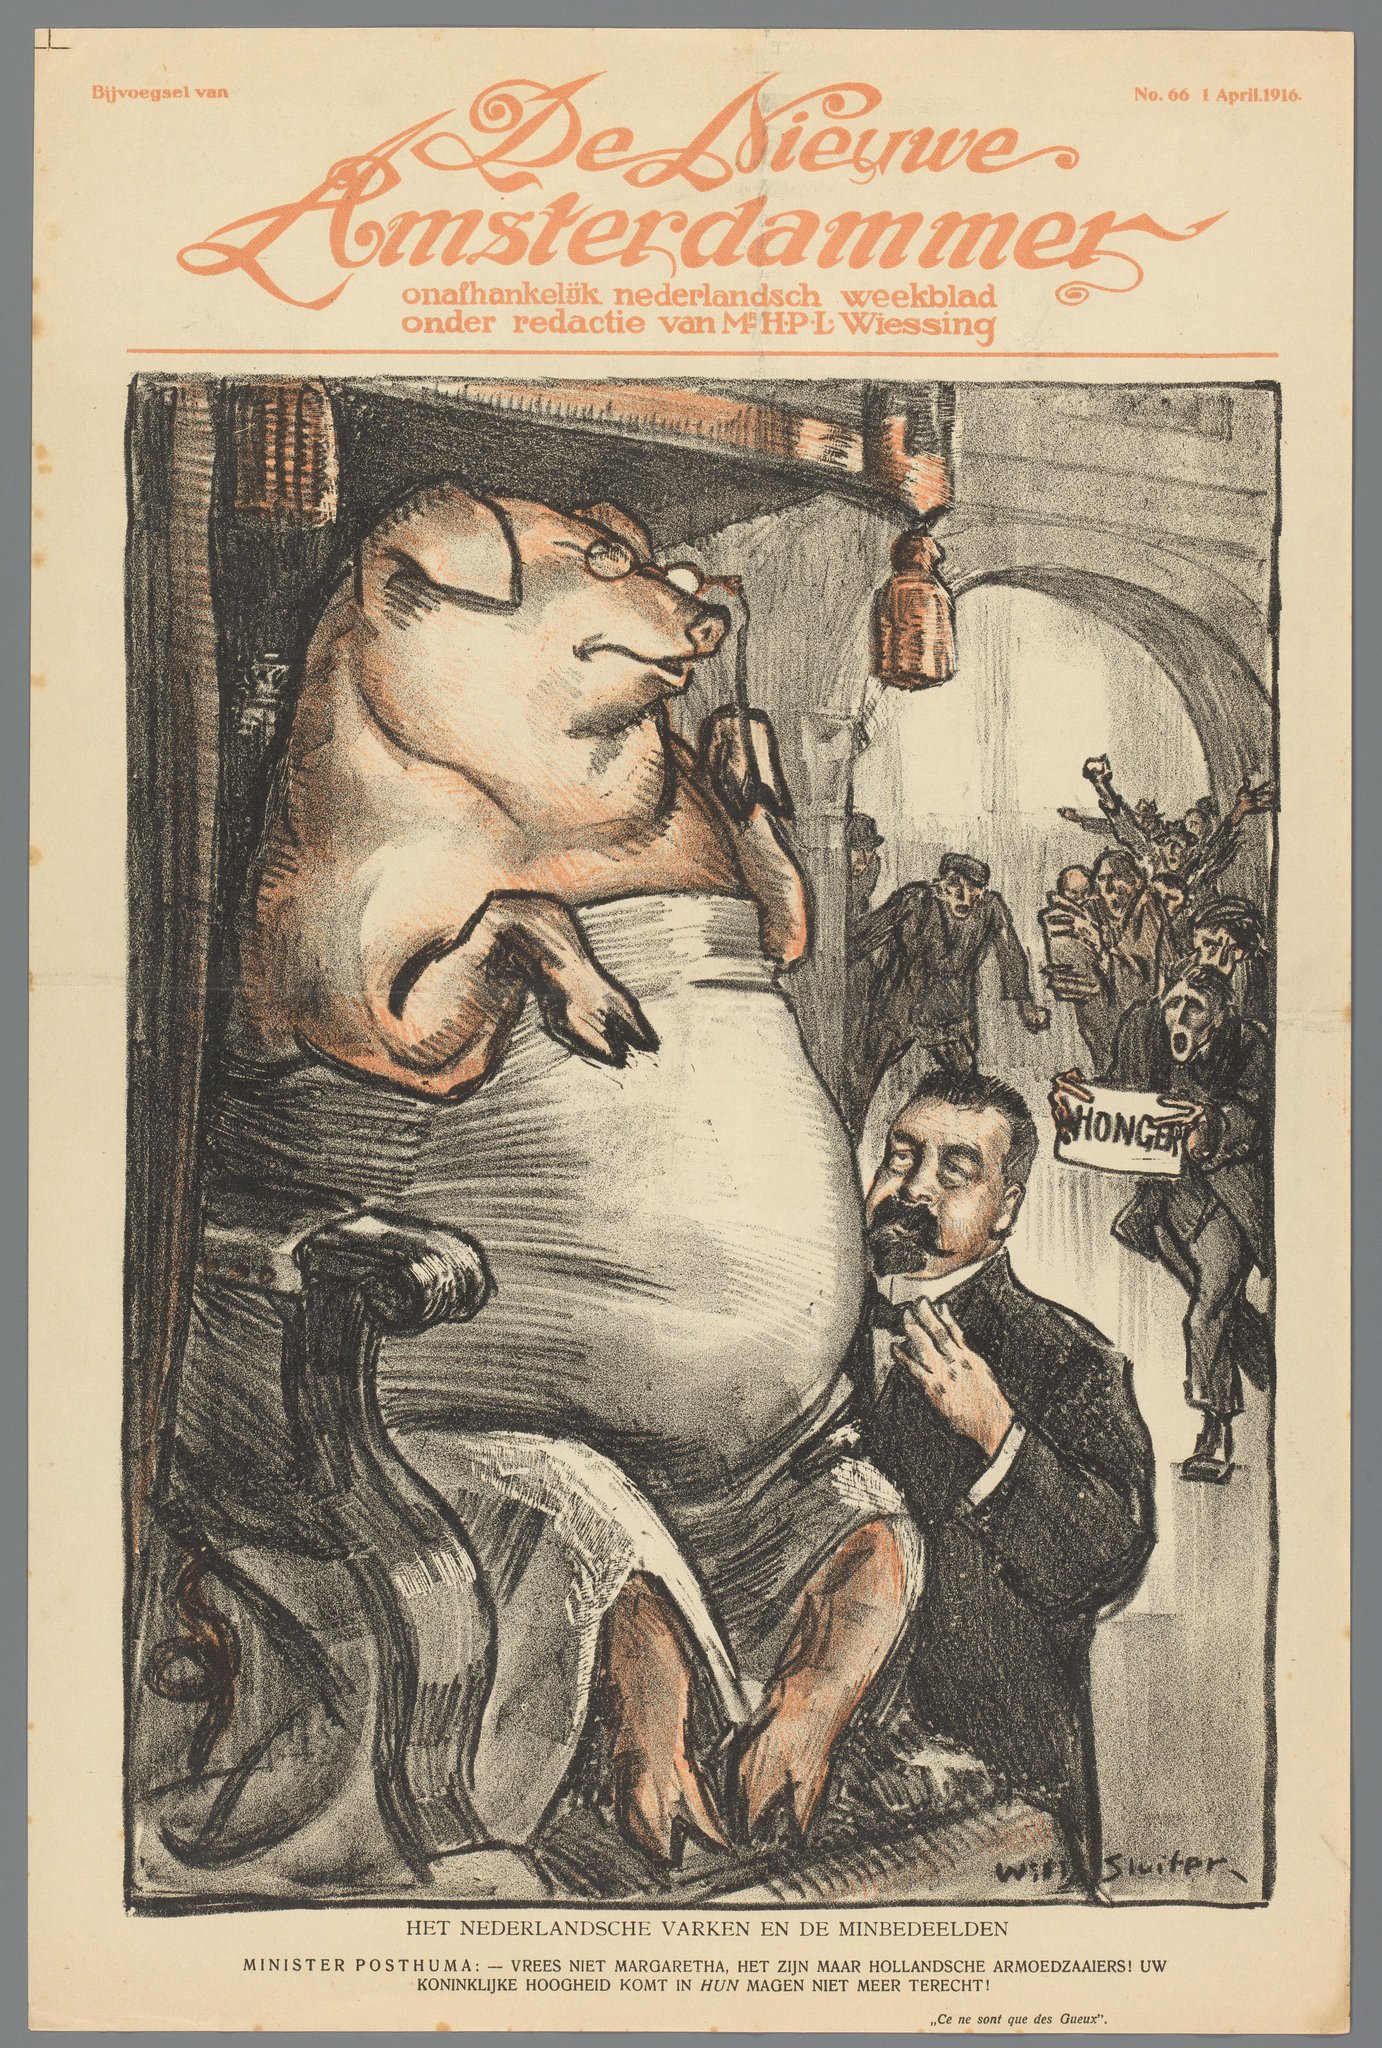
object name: cartoon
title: Het Nederlandsche varken en de minbedeelden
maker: willy sluiter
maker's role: draughtsman, painter, print maker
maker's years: 1873-1949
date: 1916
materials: paper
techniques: lithograph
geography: netherlands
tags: hunger, pig, political caricatures and satires, netherlands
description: Minister van Landbouw Folkert Posthuma verzekert het Nederlandse varken, in een pastiche op de aanbieding van het smeekschrift aan de landvoogdes Margaretha van Parma in 1566, dat zij in het distributiesysteem voor voedsel veilig is voor de smeekbeden van het hongerige volk. Spotprent over Nederlandse binnenlandse politiek, 1 april 1916.